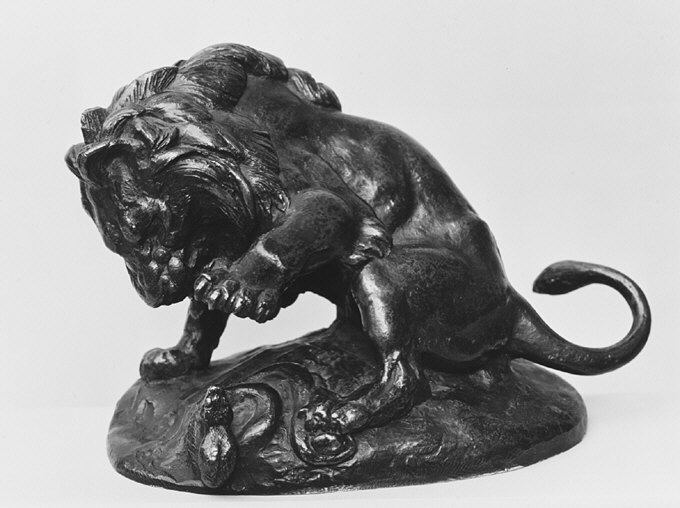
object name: statuette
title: Lion About to Strike a Serpent (Lion la patte levée sur un serpent) or (Esquisse du lion des Tuileries)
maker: antoine-louis barye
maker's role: artist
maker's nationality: french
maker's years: 1795-1875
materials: bronze, patina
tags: lions,serpents